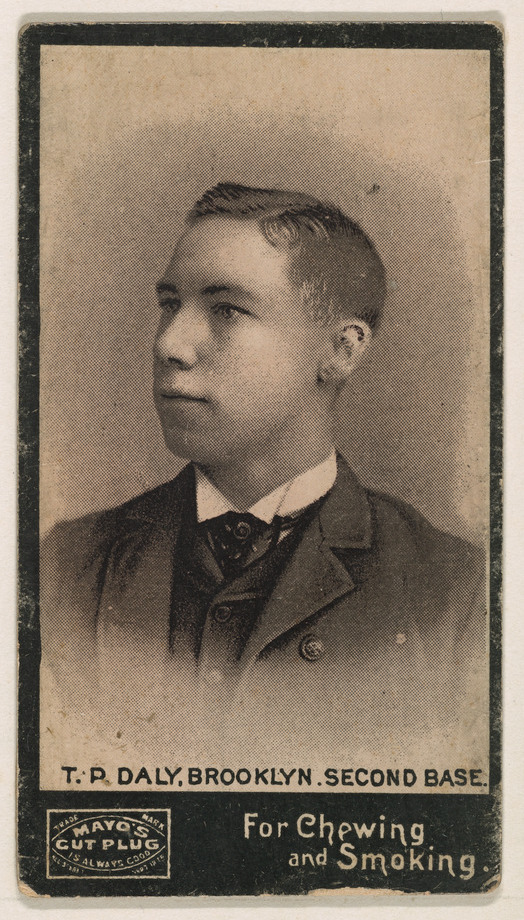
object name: print, baseball card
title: T. R. Daly, 2nd Base, Brooklyn, from Mayo's Cut Plug Baseball series (N300)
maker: p.h. mayo & brother, richmond, virginia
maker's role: publisher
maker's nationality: american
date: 1895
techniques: lithography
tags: men,portraits,baseball,athletes